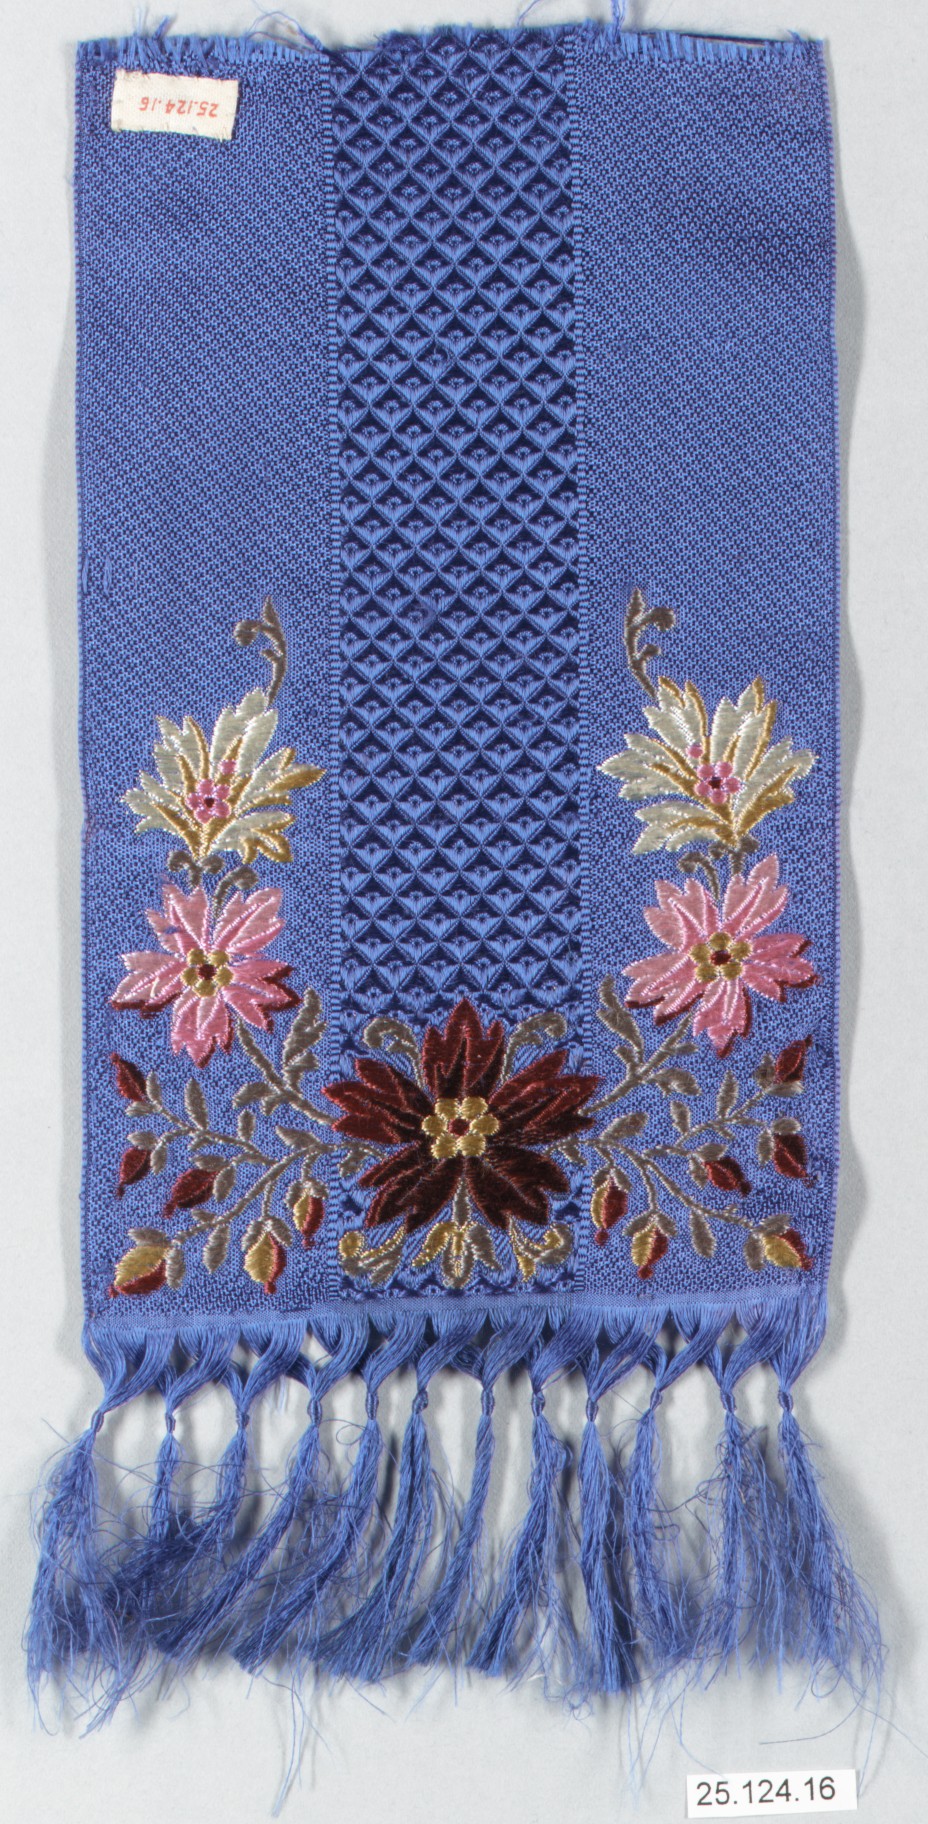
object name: necktie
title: Woman's necktie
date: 1870-1880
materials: silk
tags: flowers